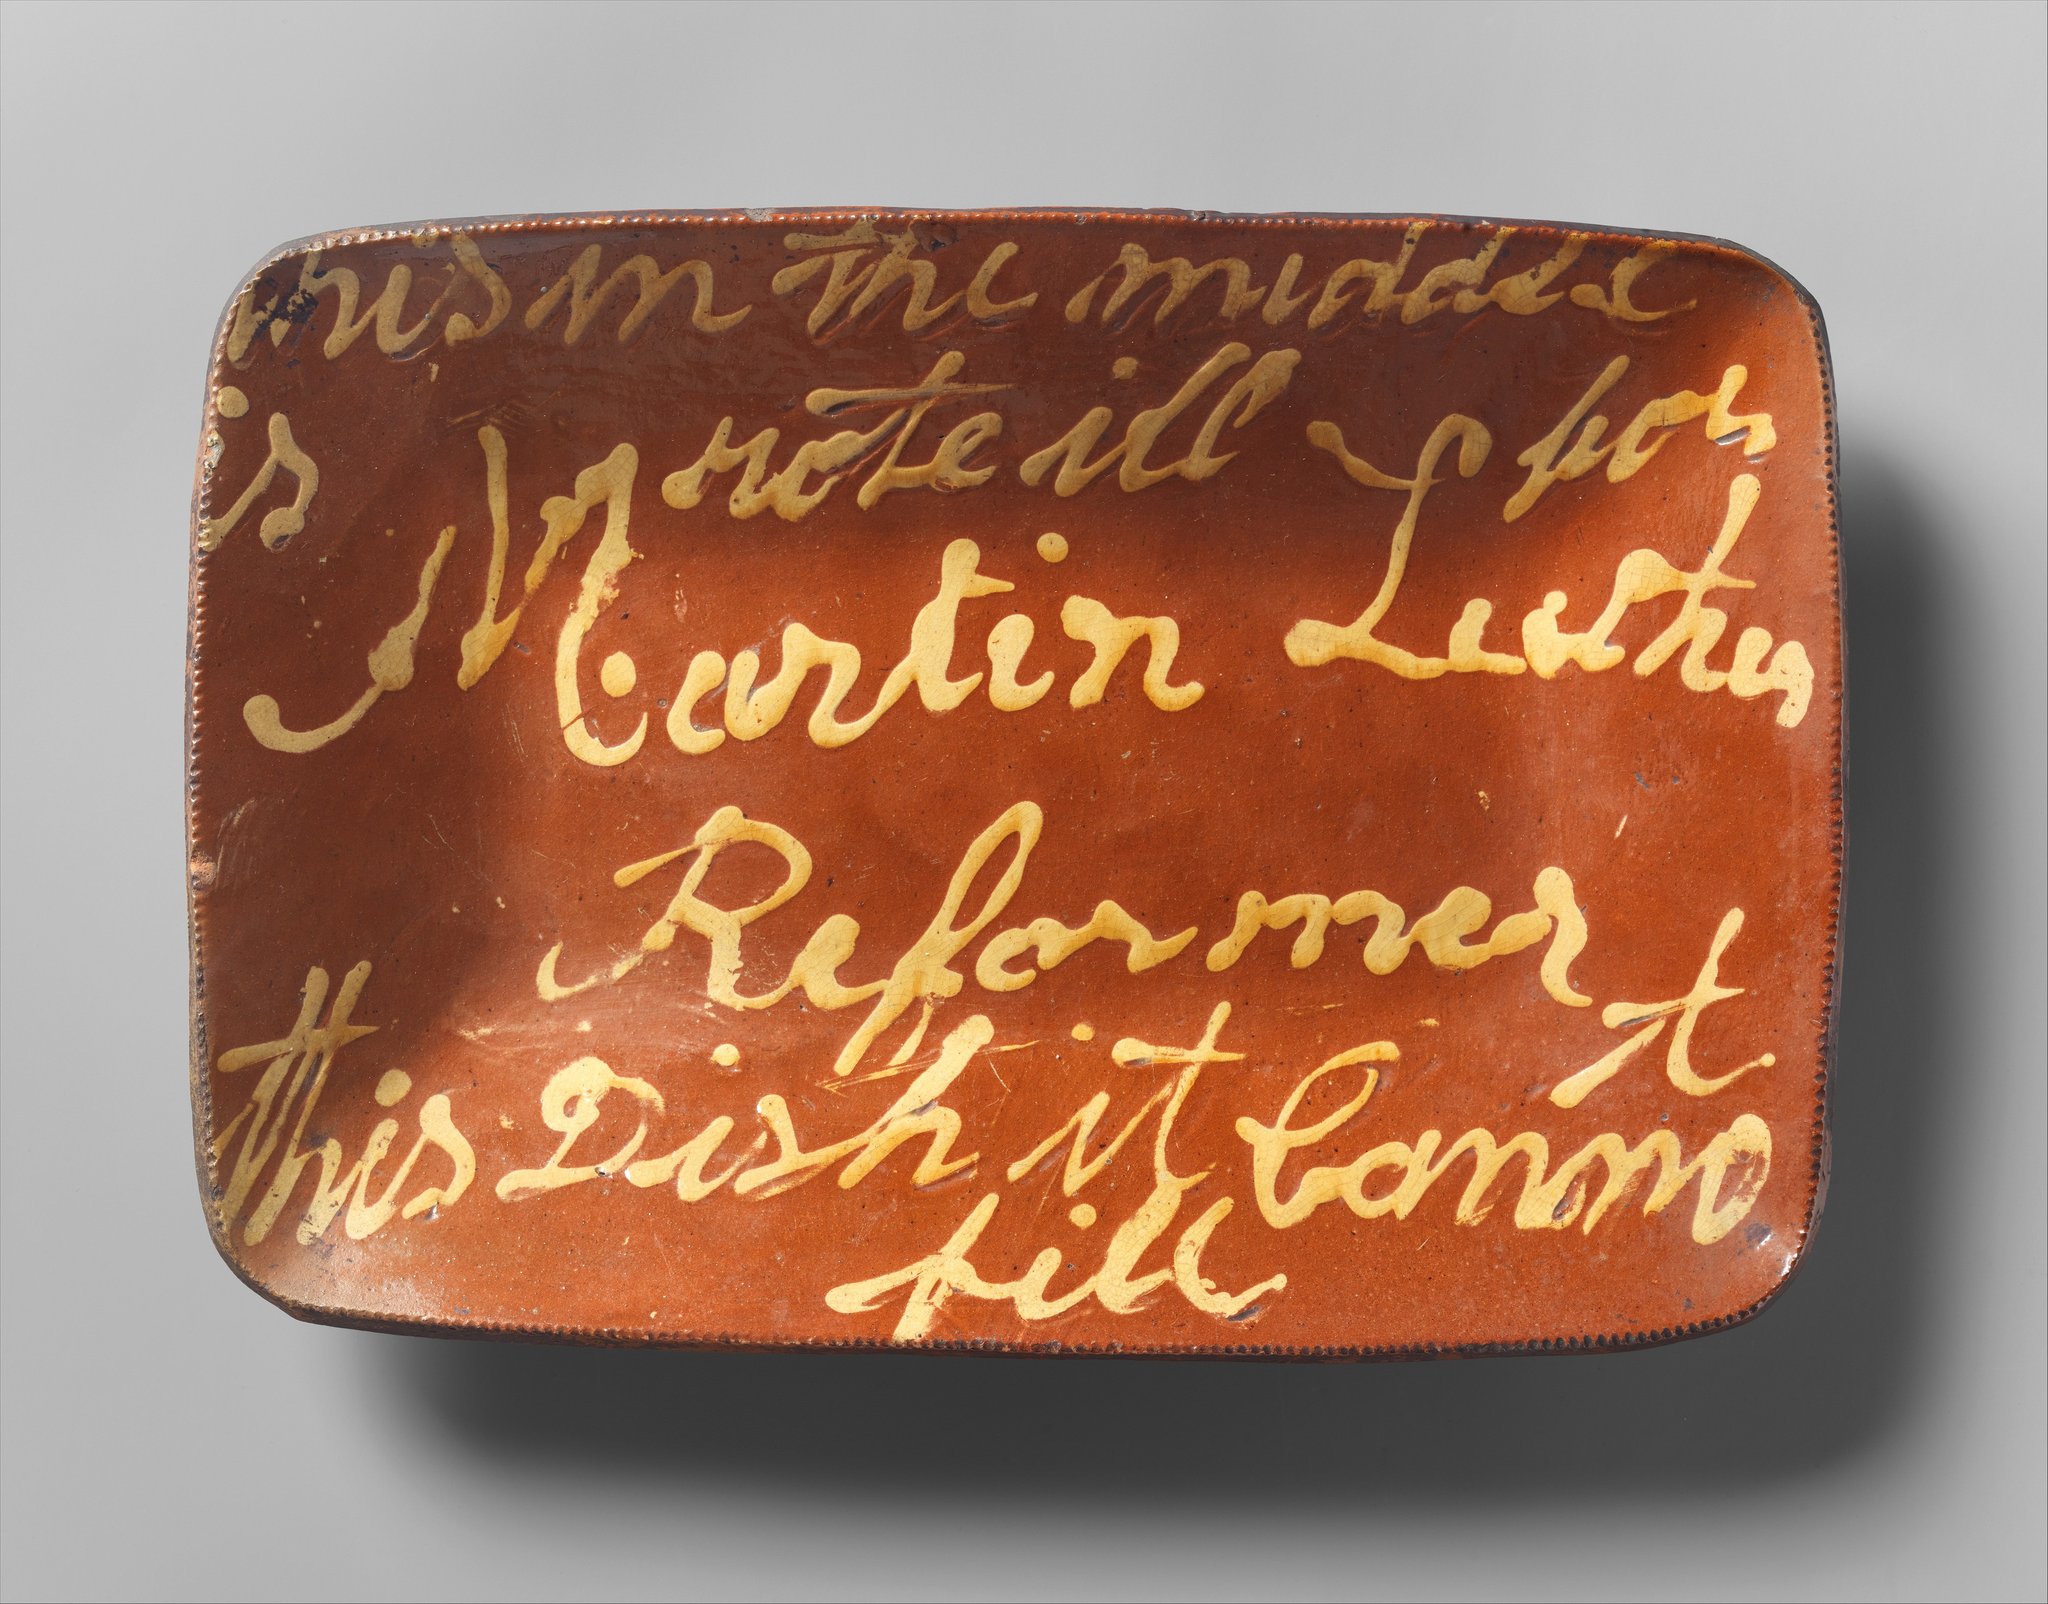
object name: dish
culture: american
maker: smith pottery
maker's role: manufacturer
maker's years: 1825-1887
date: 1825-1855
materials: earthenware, glaze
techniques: molding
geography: united states